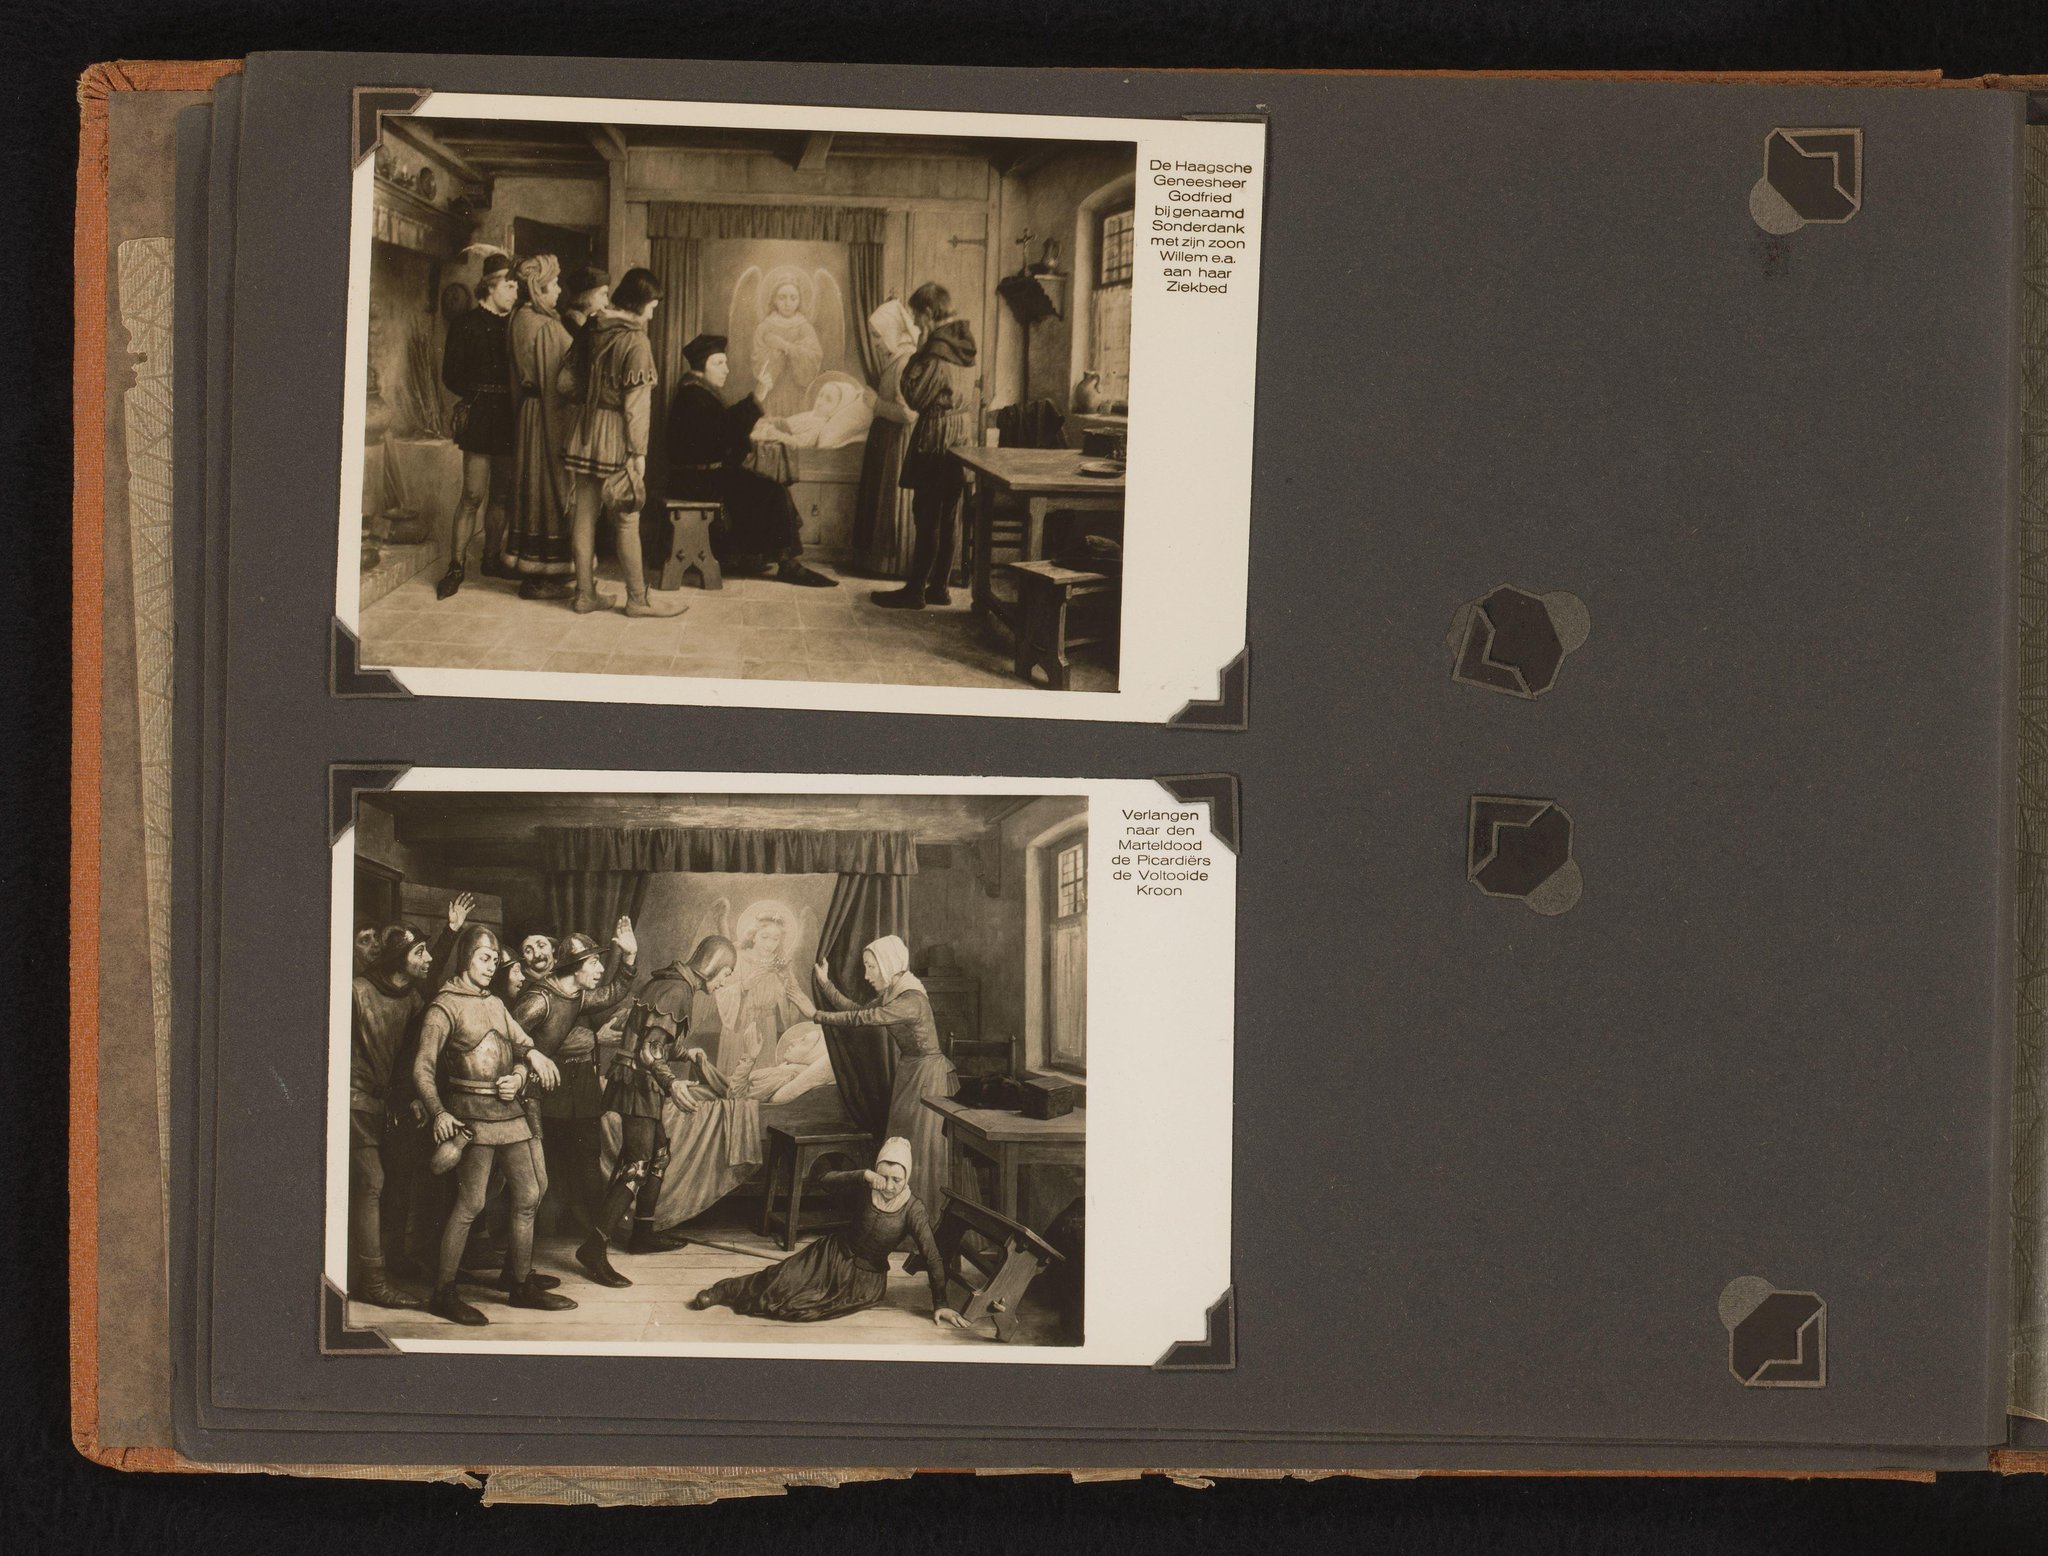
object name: album leaf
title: Prentbriefkaarten van schilderijen van de heilige Liduina van Schiedam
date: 1925-1933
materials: paper, photographic support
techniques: gelatin silver print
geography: schiedam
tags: the virgin lidwyna (lydwine) of schiedam; possible attributes: crucifix, branch of roses in hand, roses in hair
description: Albumblad met twee prentbriefkaarten naar schilderijen van de heilige Liduina van Schiedam in de St. Liduinabasiliek. Onderdeel van het Esperanto album uit ca. 1933-1936.